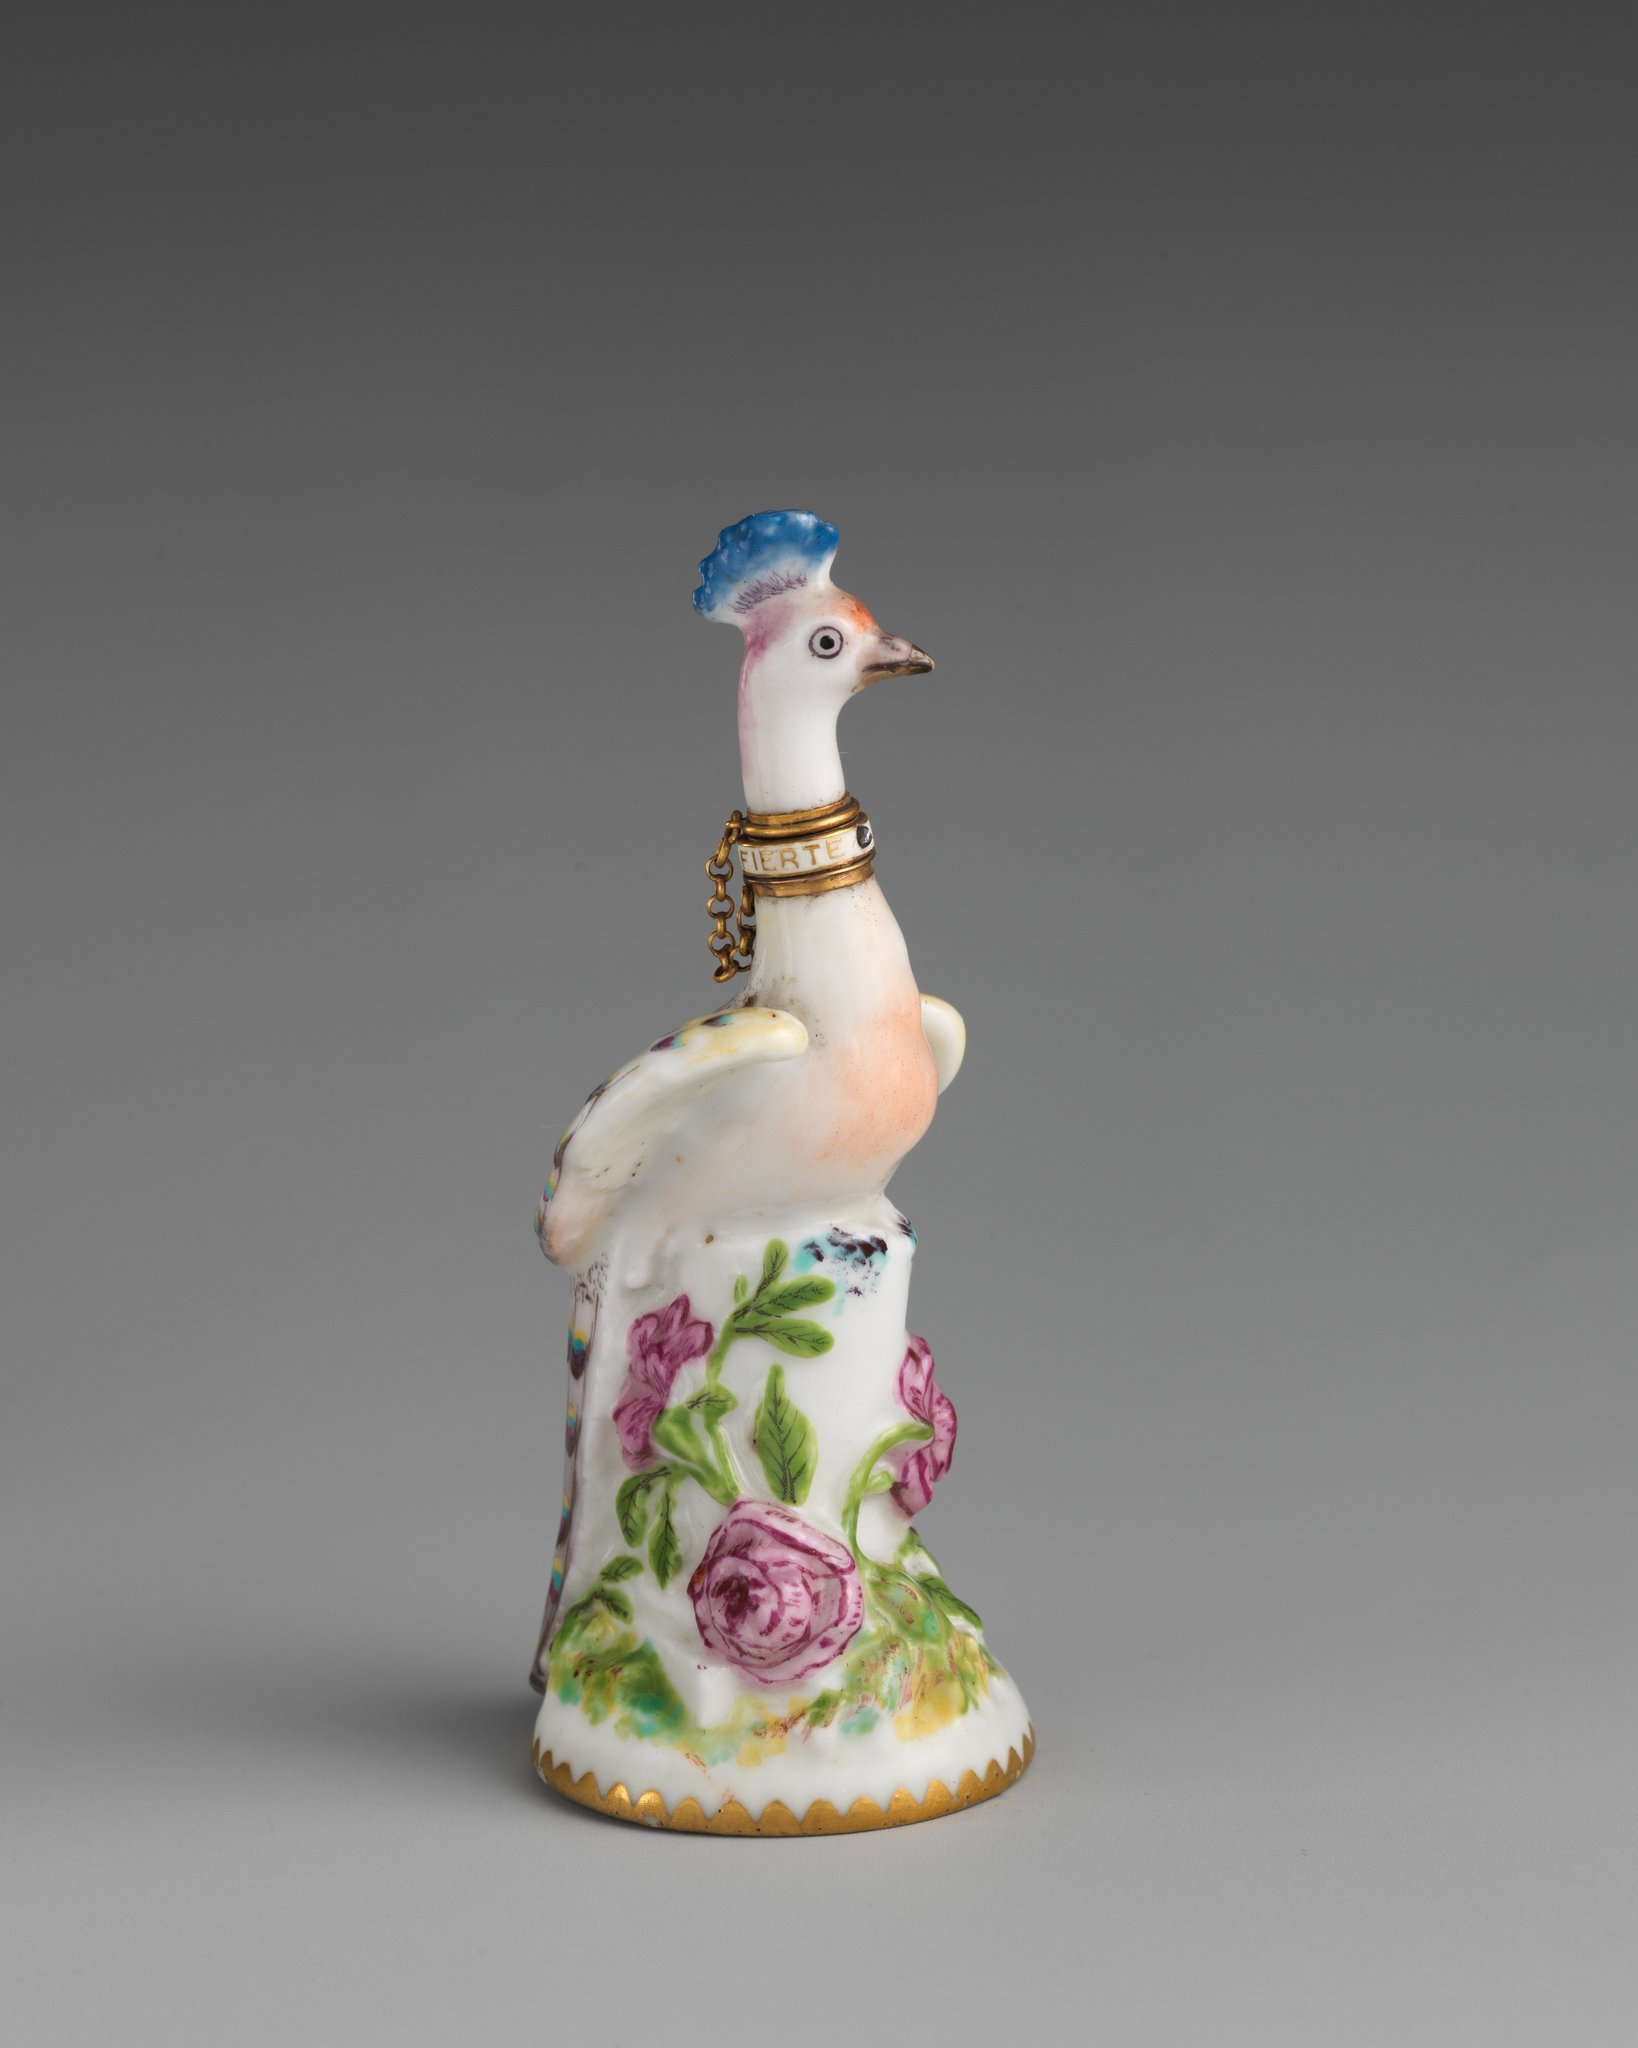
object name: toy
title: Peacock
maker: chelsea porcelain manufactory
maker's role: factory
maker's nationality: british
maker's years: 1744-1784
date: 1755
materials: diamond, soft paste porcelain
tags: peacocks,flowers,leaves